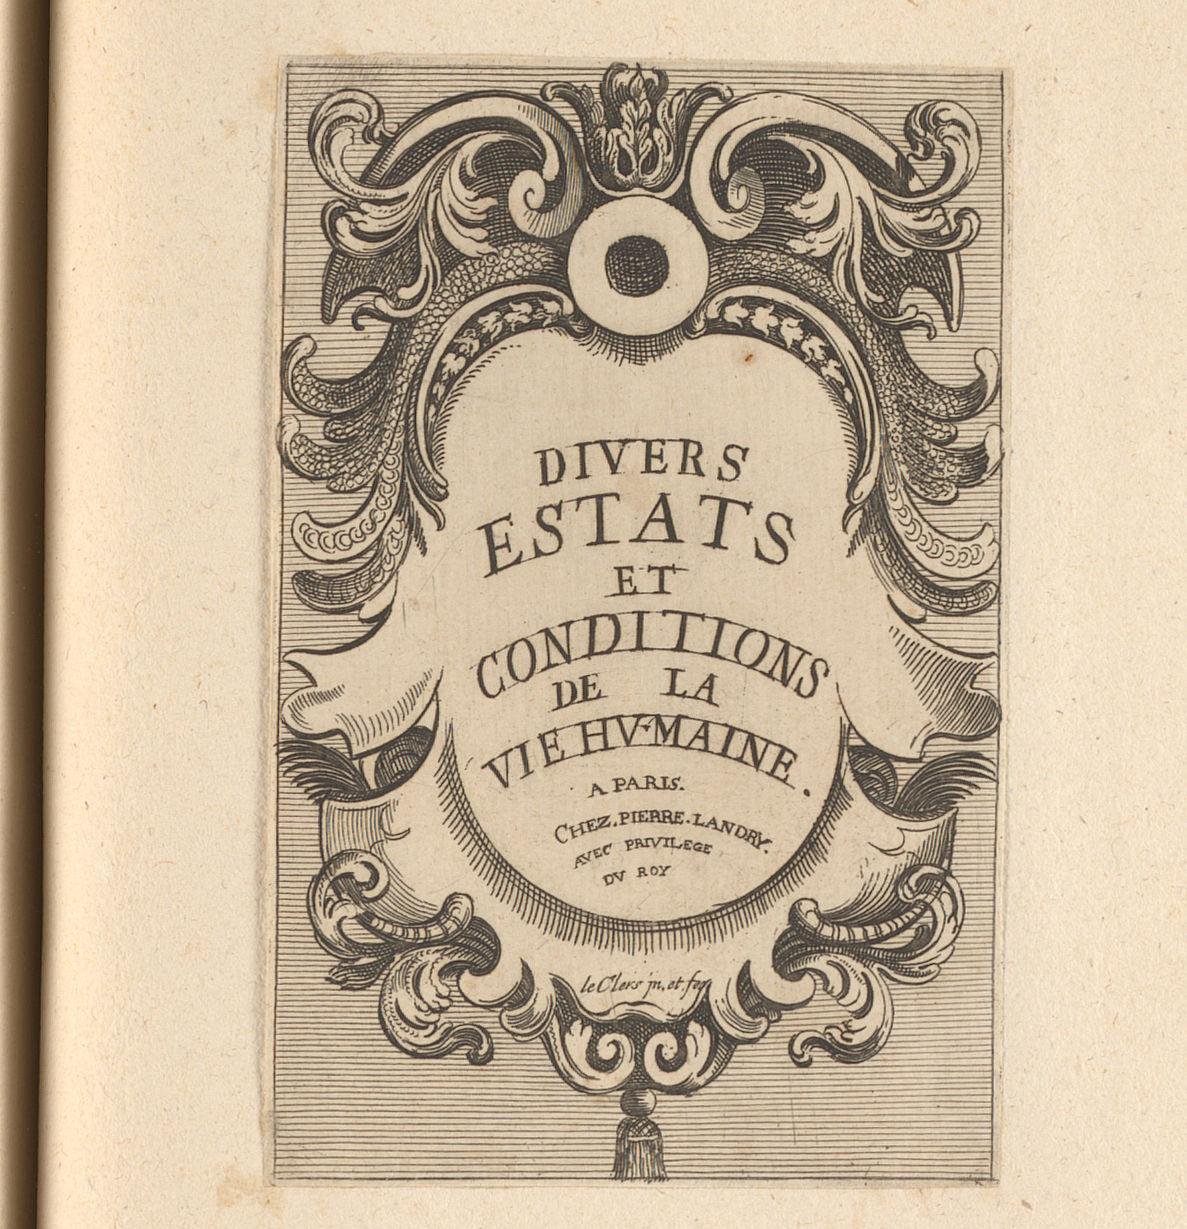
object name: titelprent, frontispice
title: Les Modes de Metz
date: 1647-1701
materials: paper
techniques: etching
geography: metz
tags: ornament ~ cartouche, folk costume, regional costume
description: Titelprent van een 28-delige serie met verschillende figuren uit Metz in de regionale mode. Leclerc vervaardigde de platen te Metz. Landry gaf slechts twintig van de prenten in een serie uit.